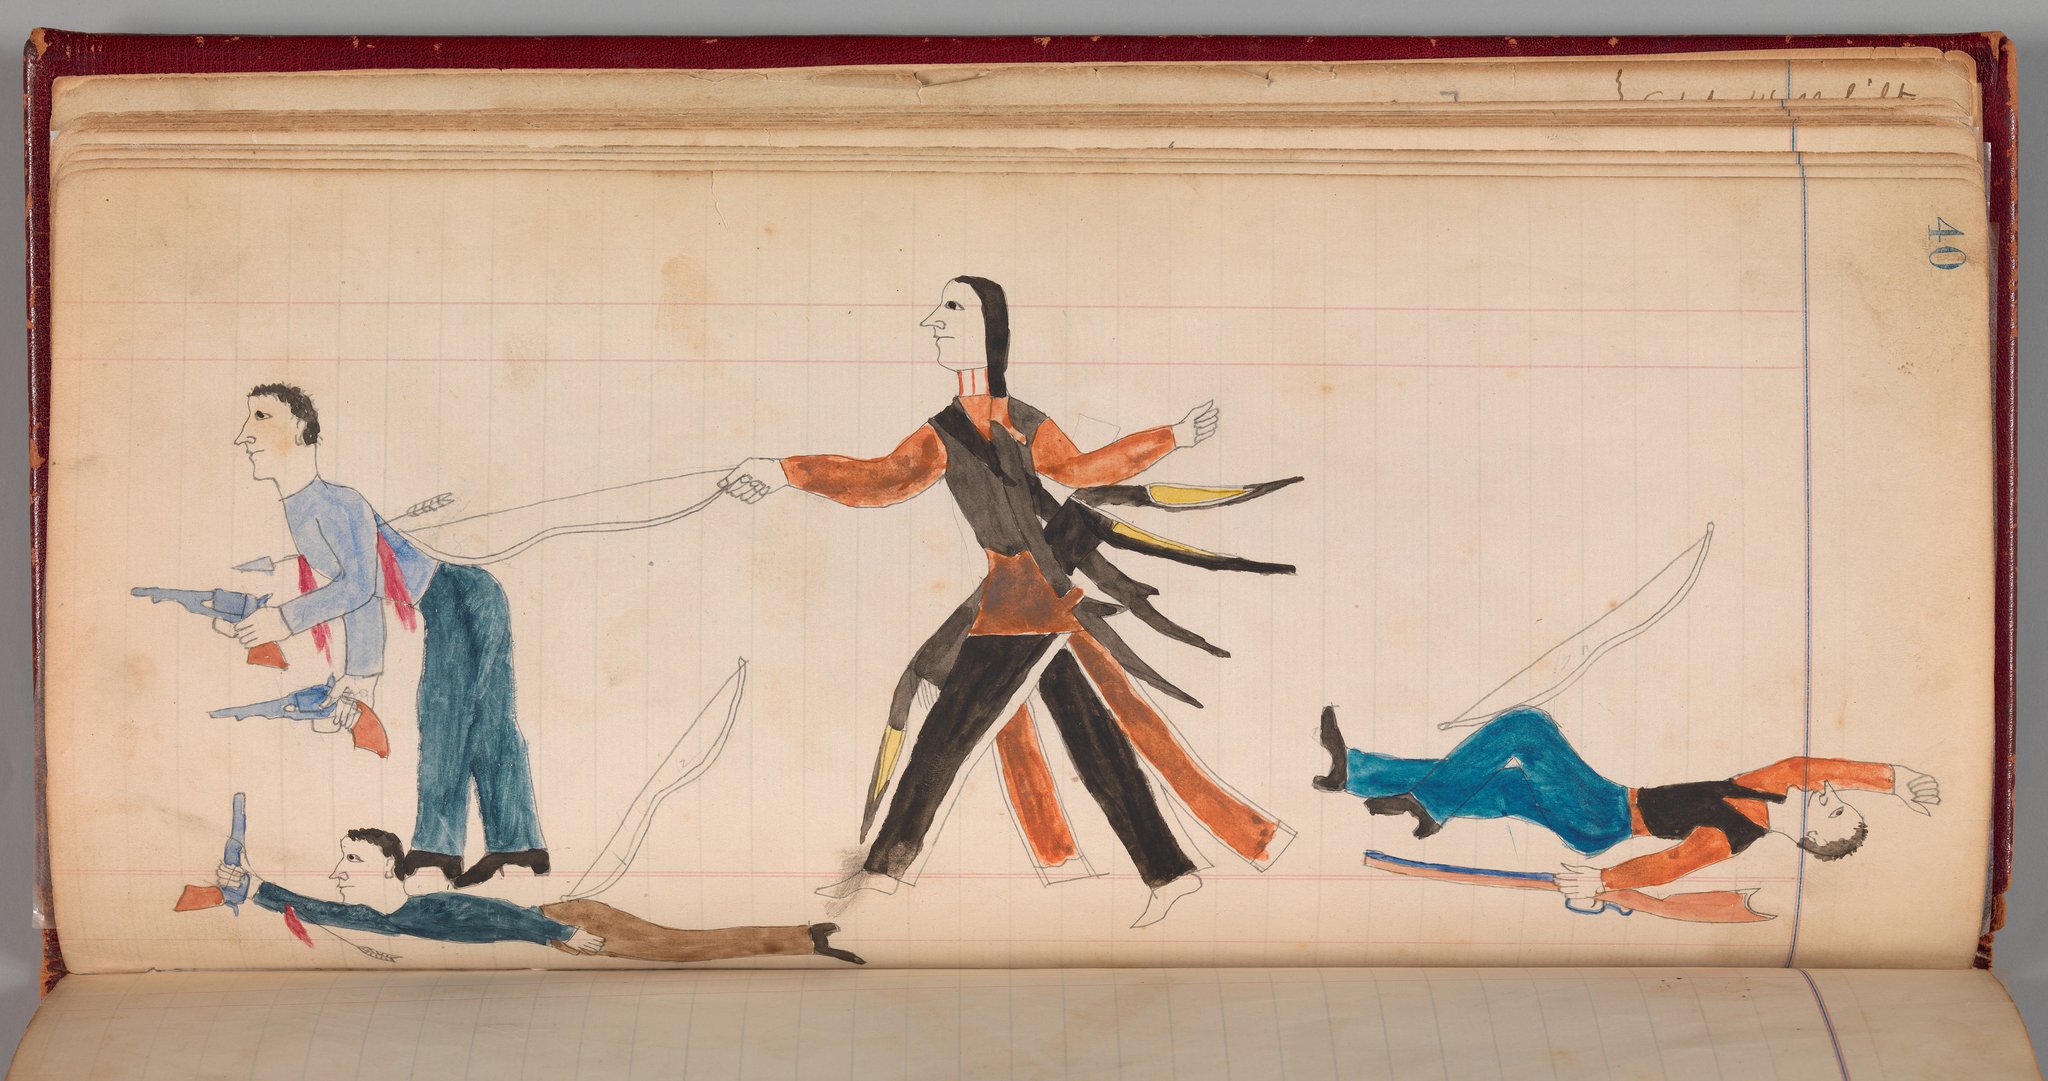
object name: drawing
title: Maffet Ledger: Indian and three white men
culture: cheyenne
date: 1874-1881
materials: crayon, graphite, paper, watercolor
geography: united states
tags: firearms,men